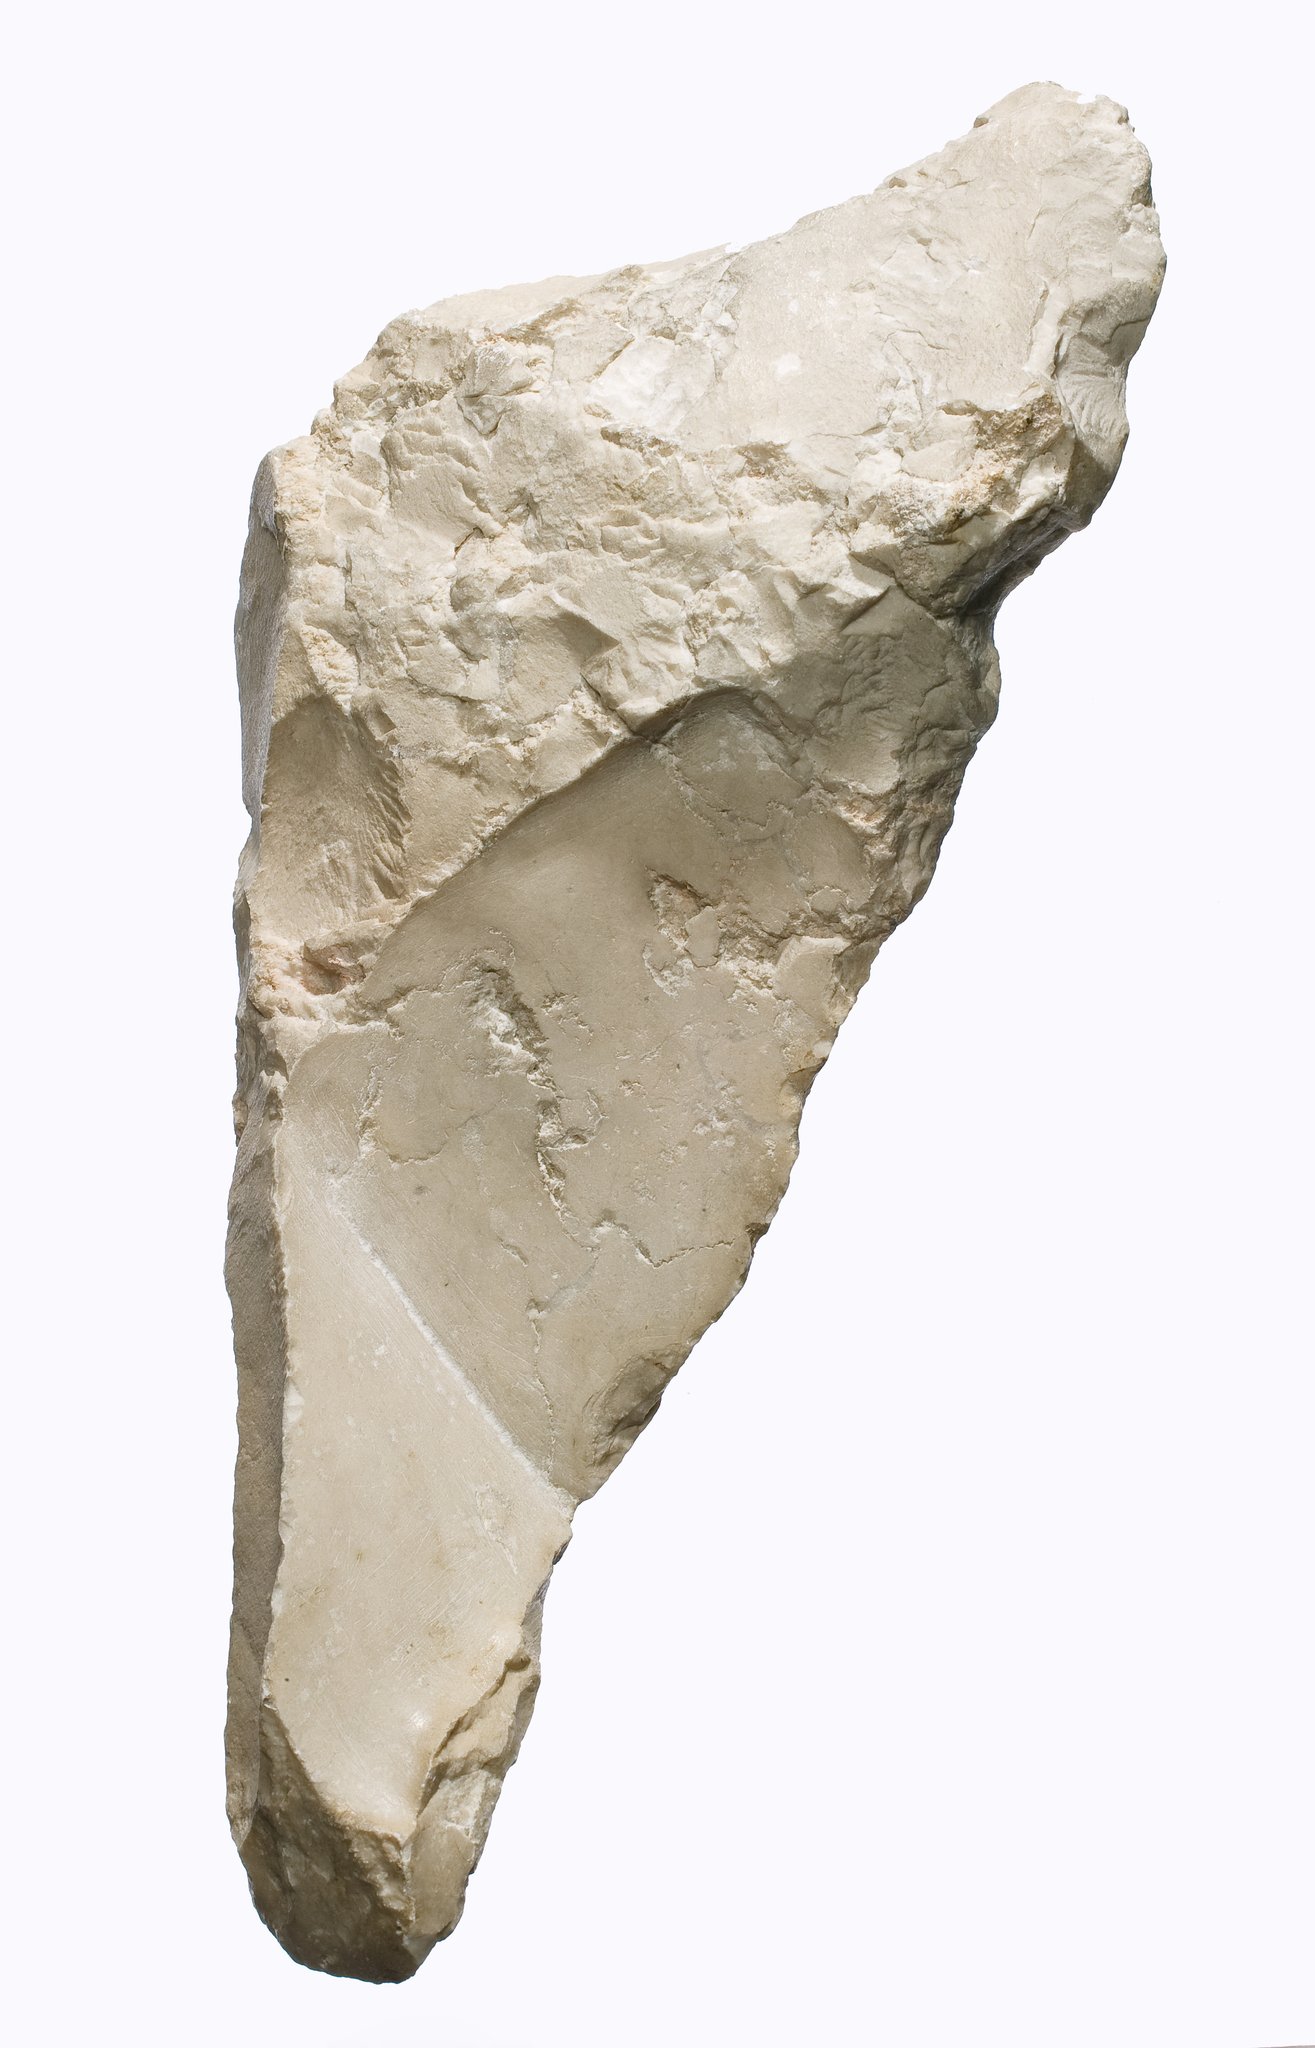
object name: akhenaten or nefertiti prostrate, foot leg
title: Foot and leg of Akhenaten or Nefertiti prostrate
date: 1352-1336 BCE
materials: limestone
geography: egypt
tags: feet